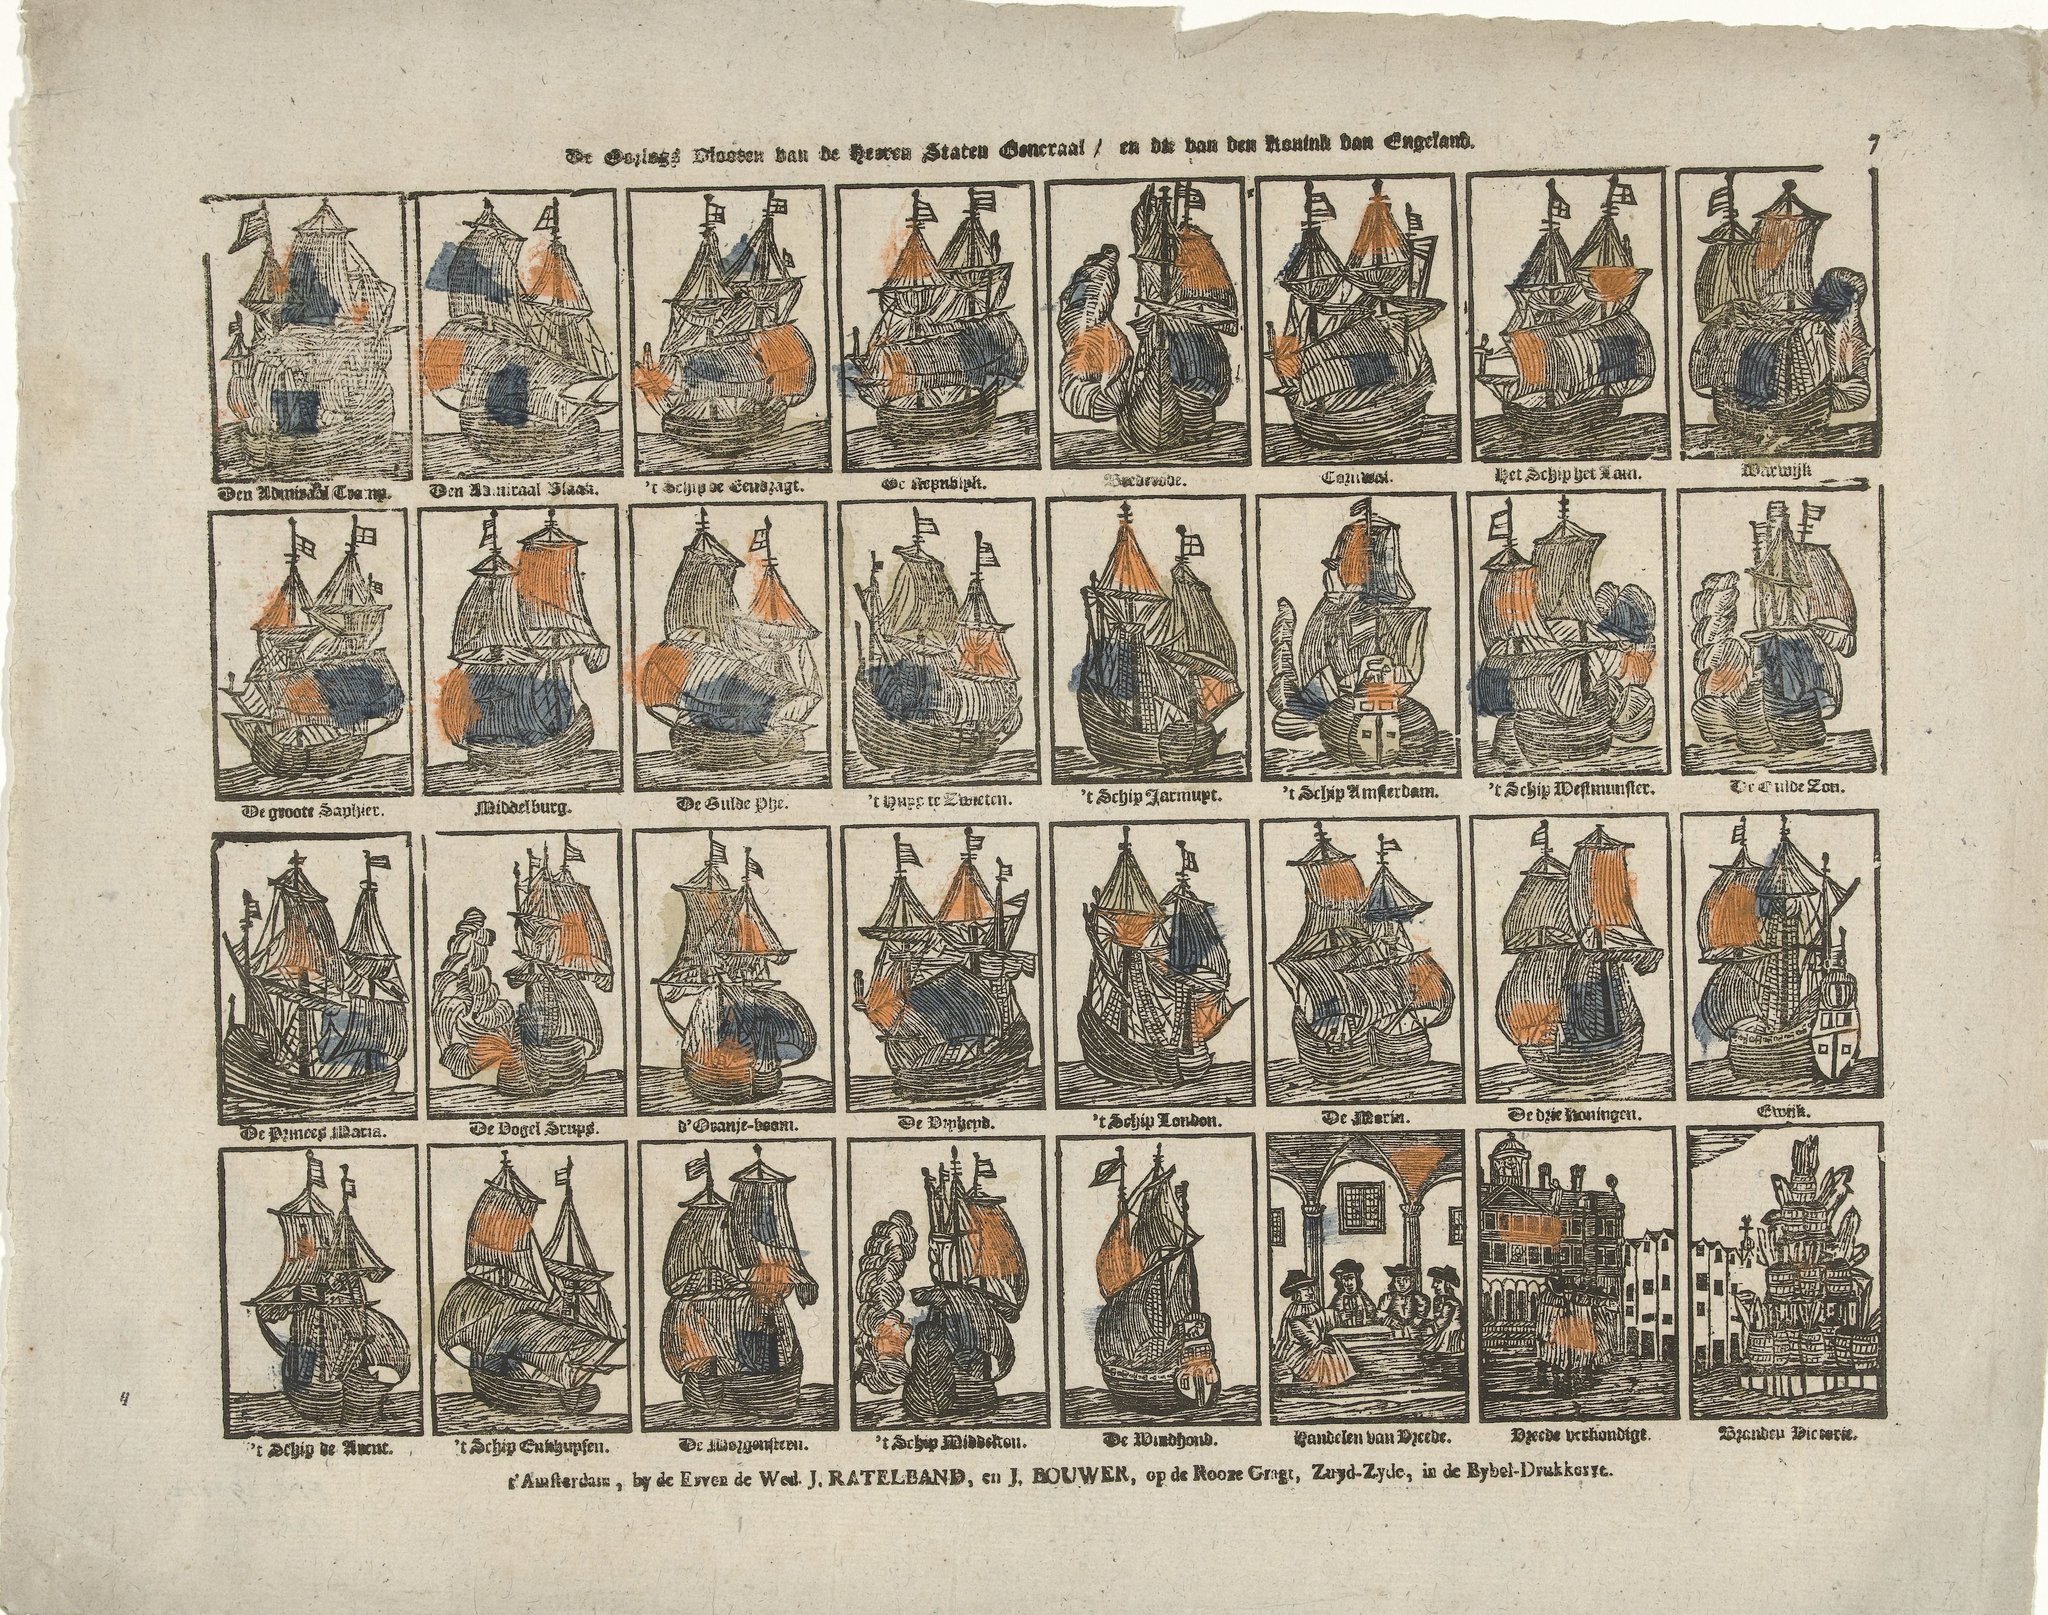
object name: popular print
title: De oorlogs vlooten van de heeren staten generaal / en die van den konink van Engeland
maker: Anonymous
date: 1782-1793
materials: paper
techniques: colour, letterpress printing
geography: netherlands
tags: ships (in general) (+ propulsion of vehicle, ship, etc. by wind), battle (+ naval force)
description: Blad met 32 voorstellingen van oorlogsschepen van de Republiek en van Engeland, de laatste 3 voorstellingen over de vrede gesloten tussen de Republiek en Engeland in 1654. Onder elke afbeelding de naam van het schip. Genummerd rechtsboven: 7.